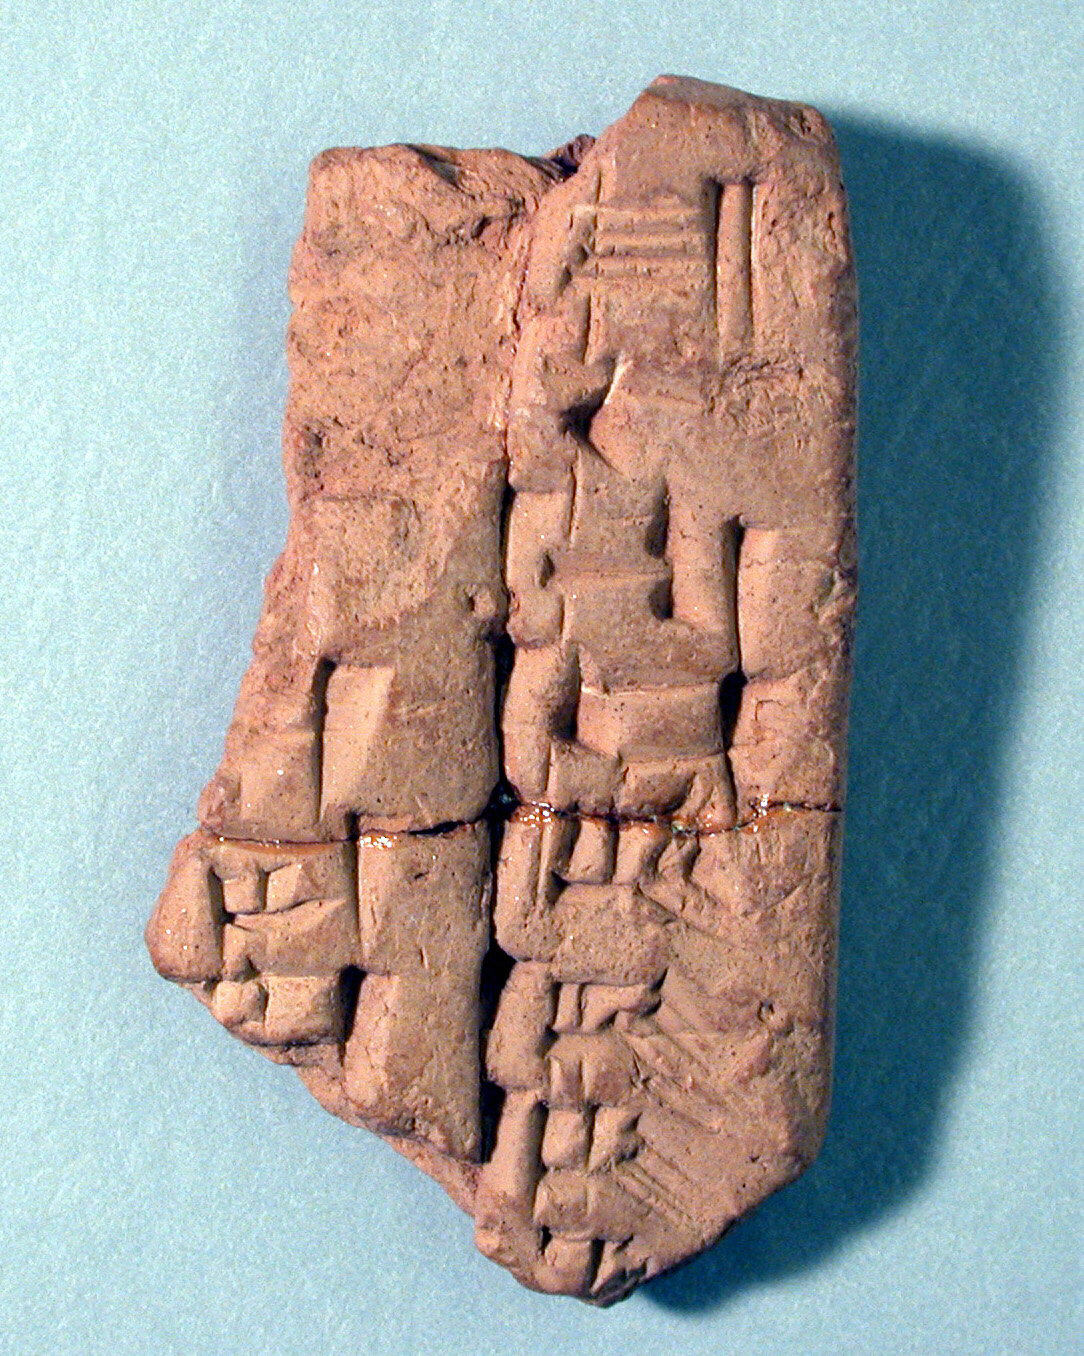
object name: cuneiform tablet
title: Cuneiform tablet: fragment of Syllabary A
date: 333-1 BCE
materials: clay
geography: mesopotamia